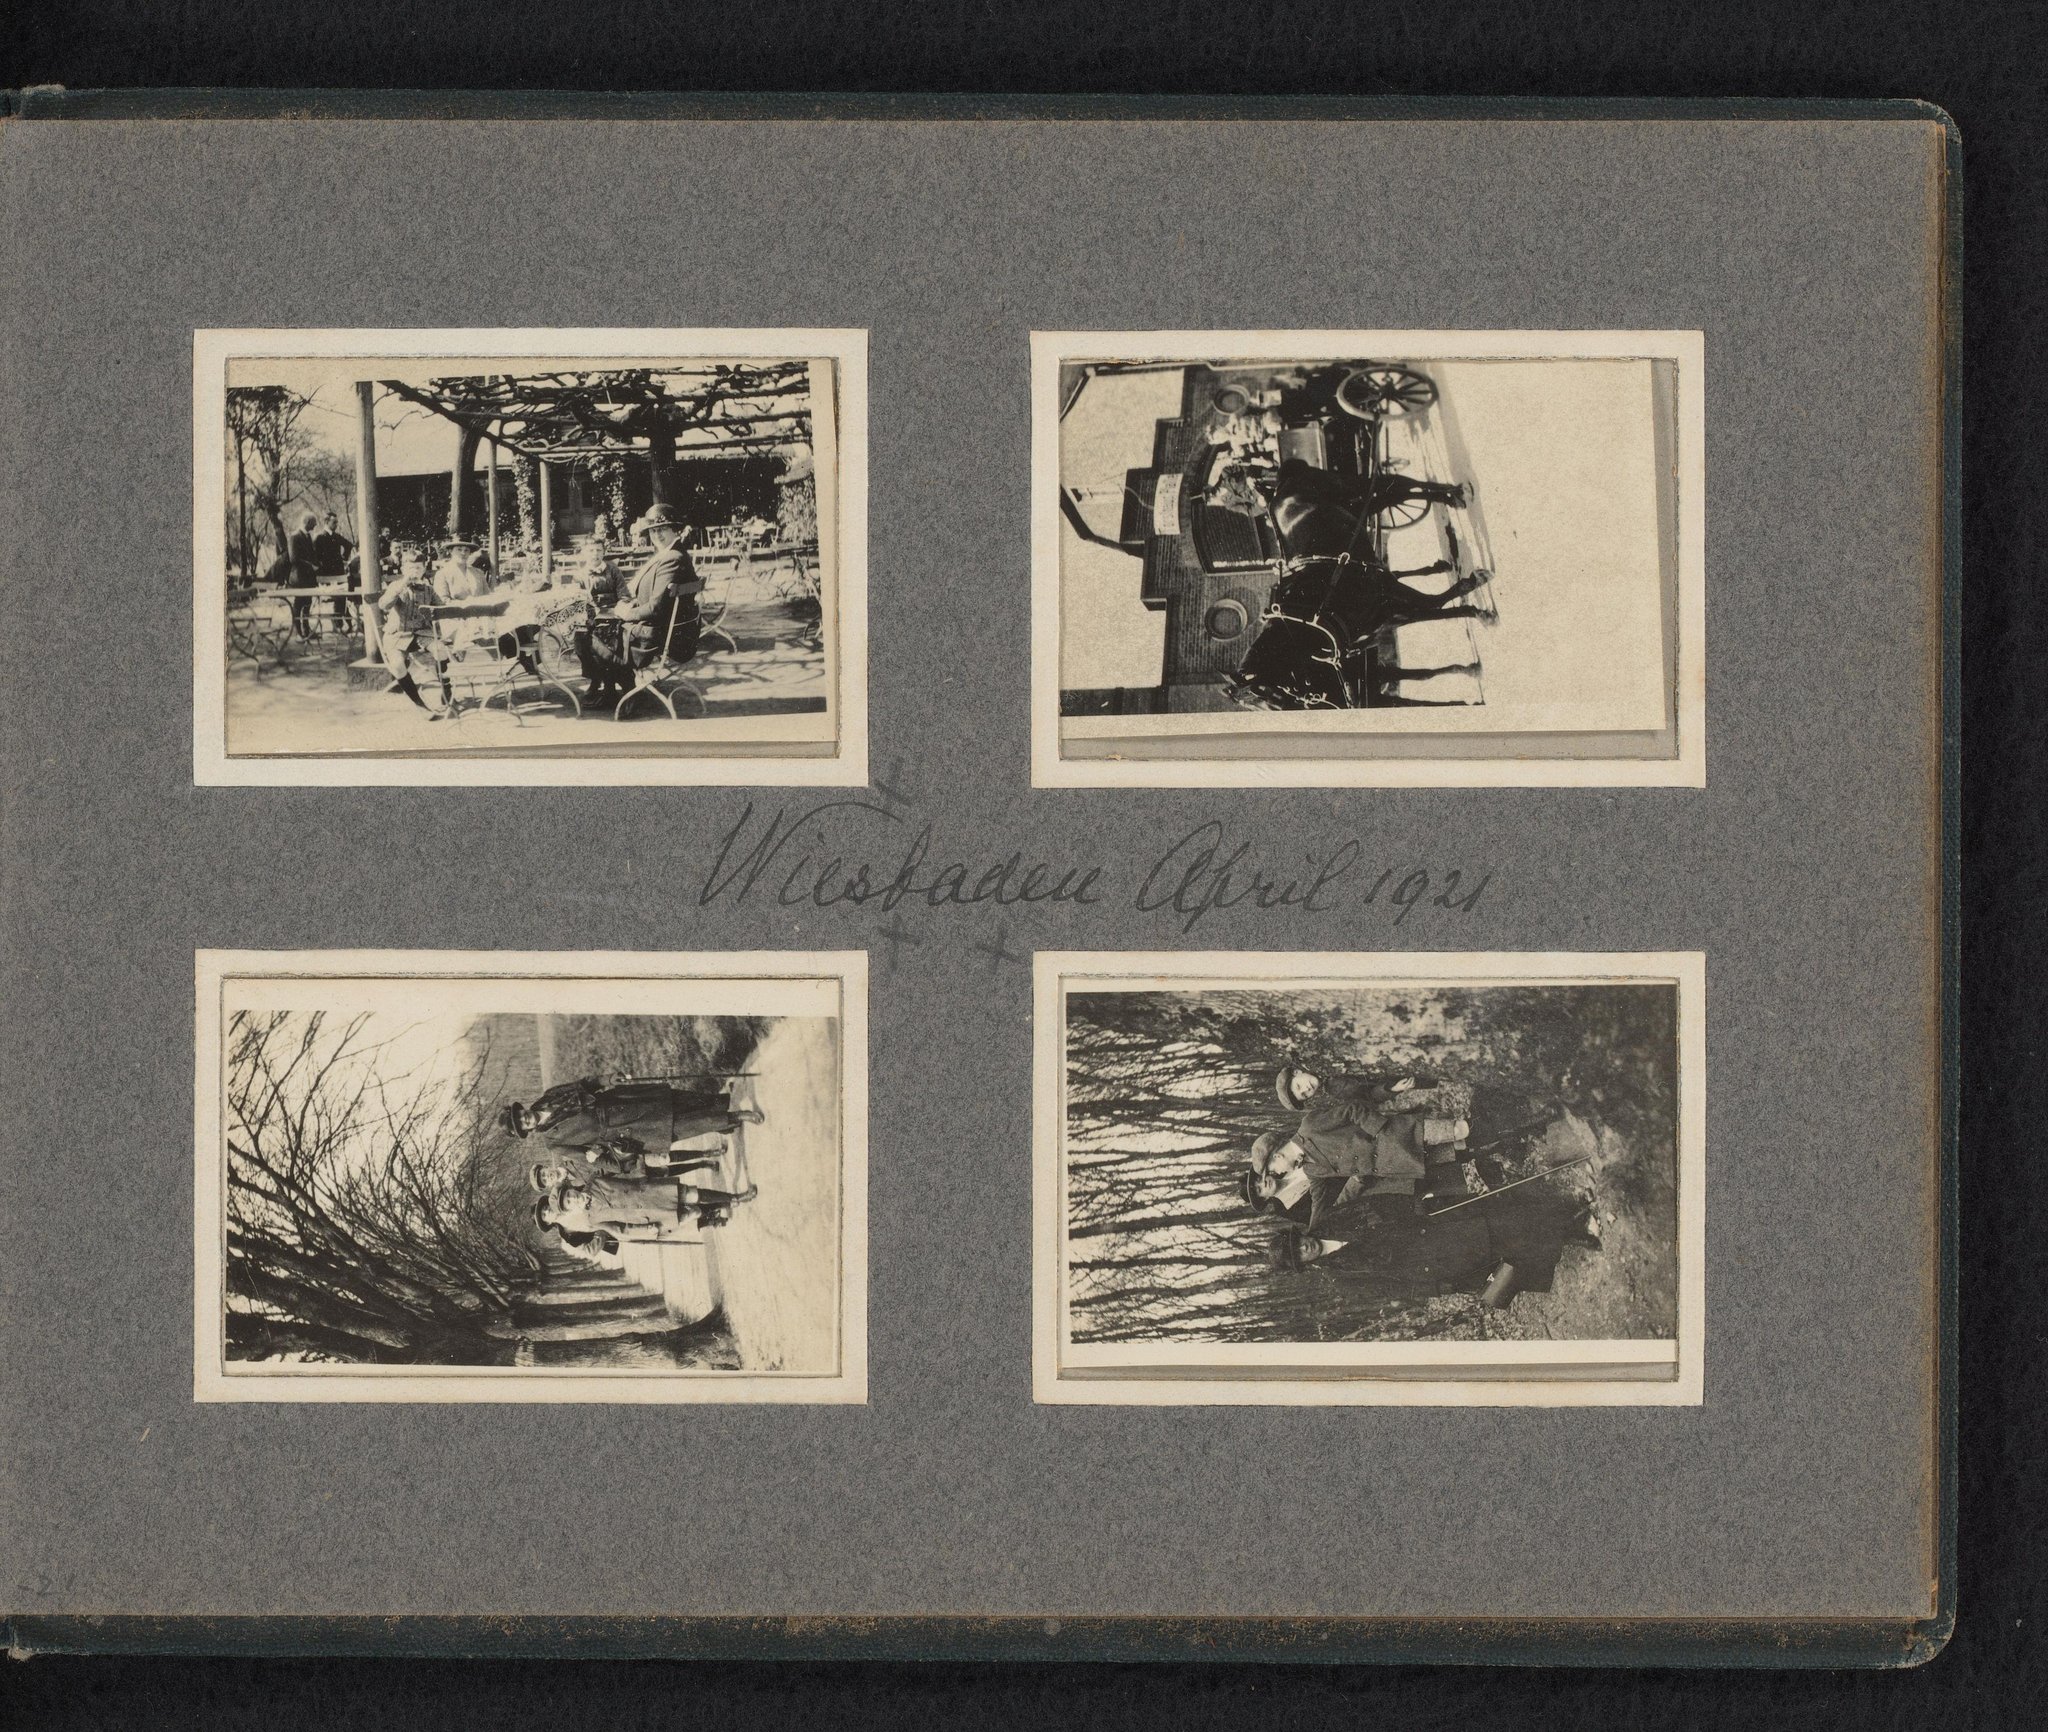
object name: photograph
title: Caroline, Carel en Frank van den berg in Wiesbaden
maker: hendrik herman van den berg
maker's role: amateurfotograaf, jurist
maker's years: 1875-1944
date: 1904-1921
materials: paper, cardboard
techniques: gelatin silver print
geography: wiesbaden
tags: the hague, caroline louise van den berg-van den berg, amsterdam, carel frederik van den berg (cay), frank willem van den berg (1912-1998), family life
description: Deze foto's zijn onderdeel van een album.